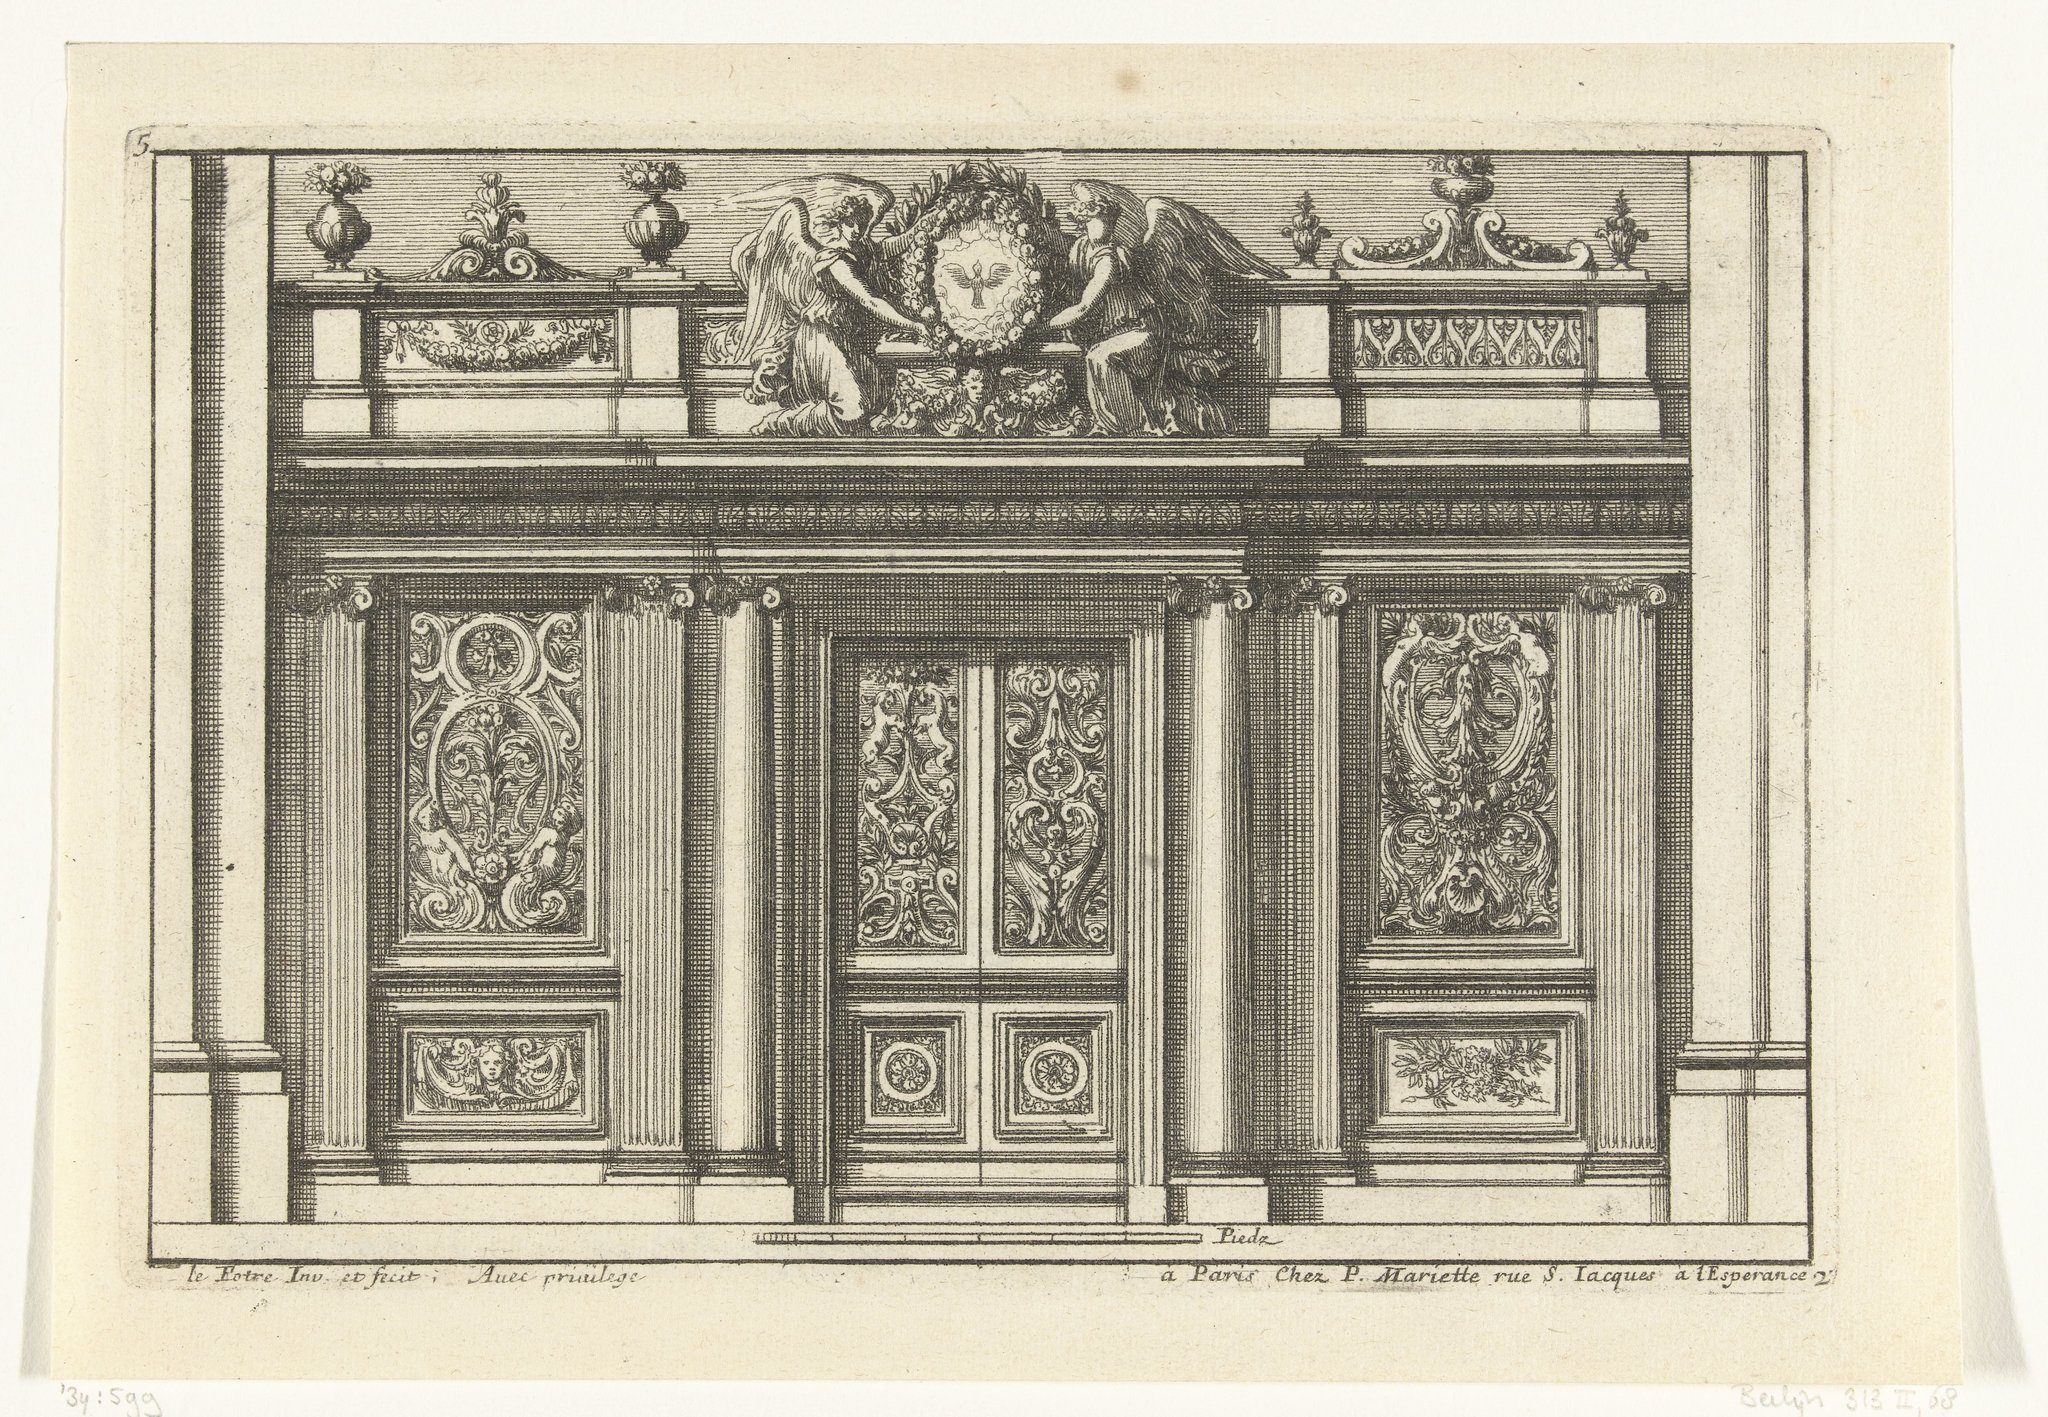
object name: ornament print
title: Koorhekken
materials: paper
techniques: etching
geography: france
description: De engelen dragen een cartouche met de Heilige Geest. Met een variant voor de rechterhelft. Uit derde editie.